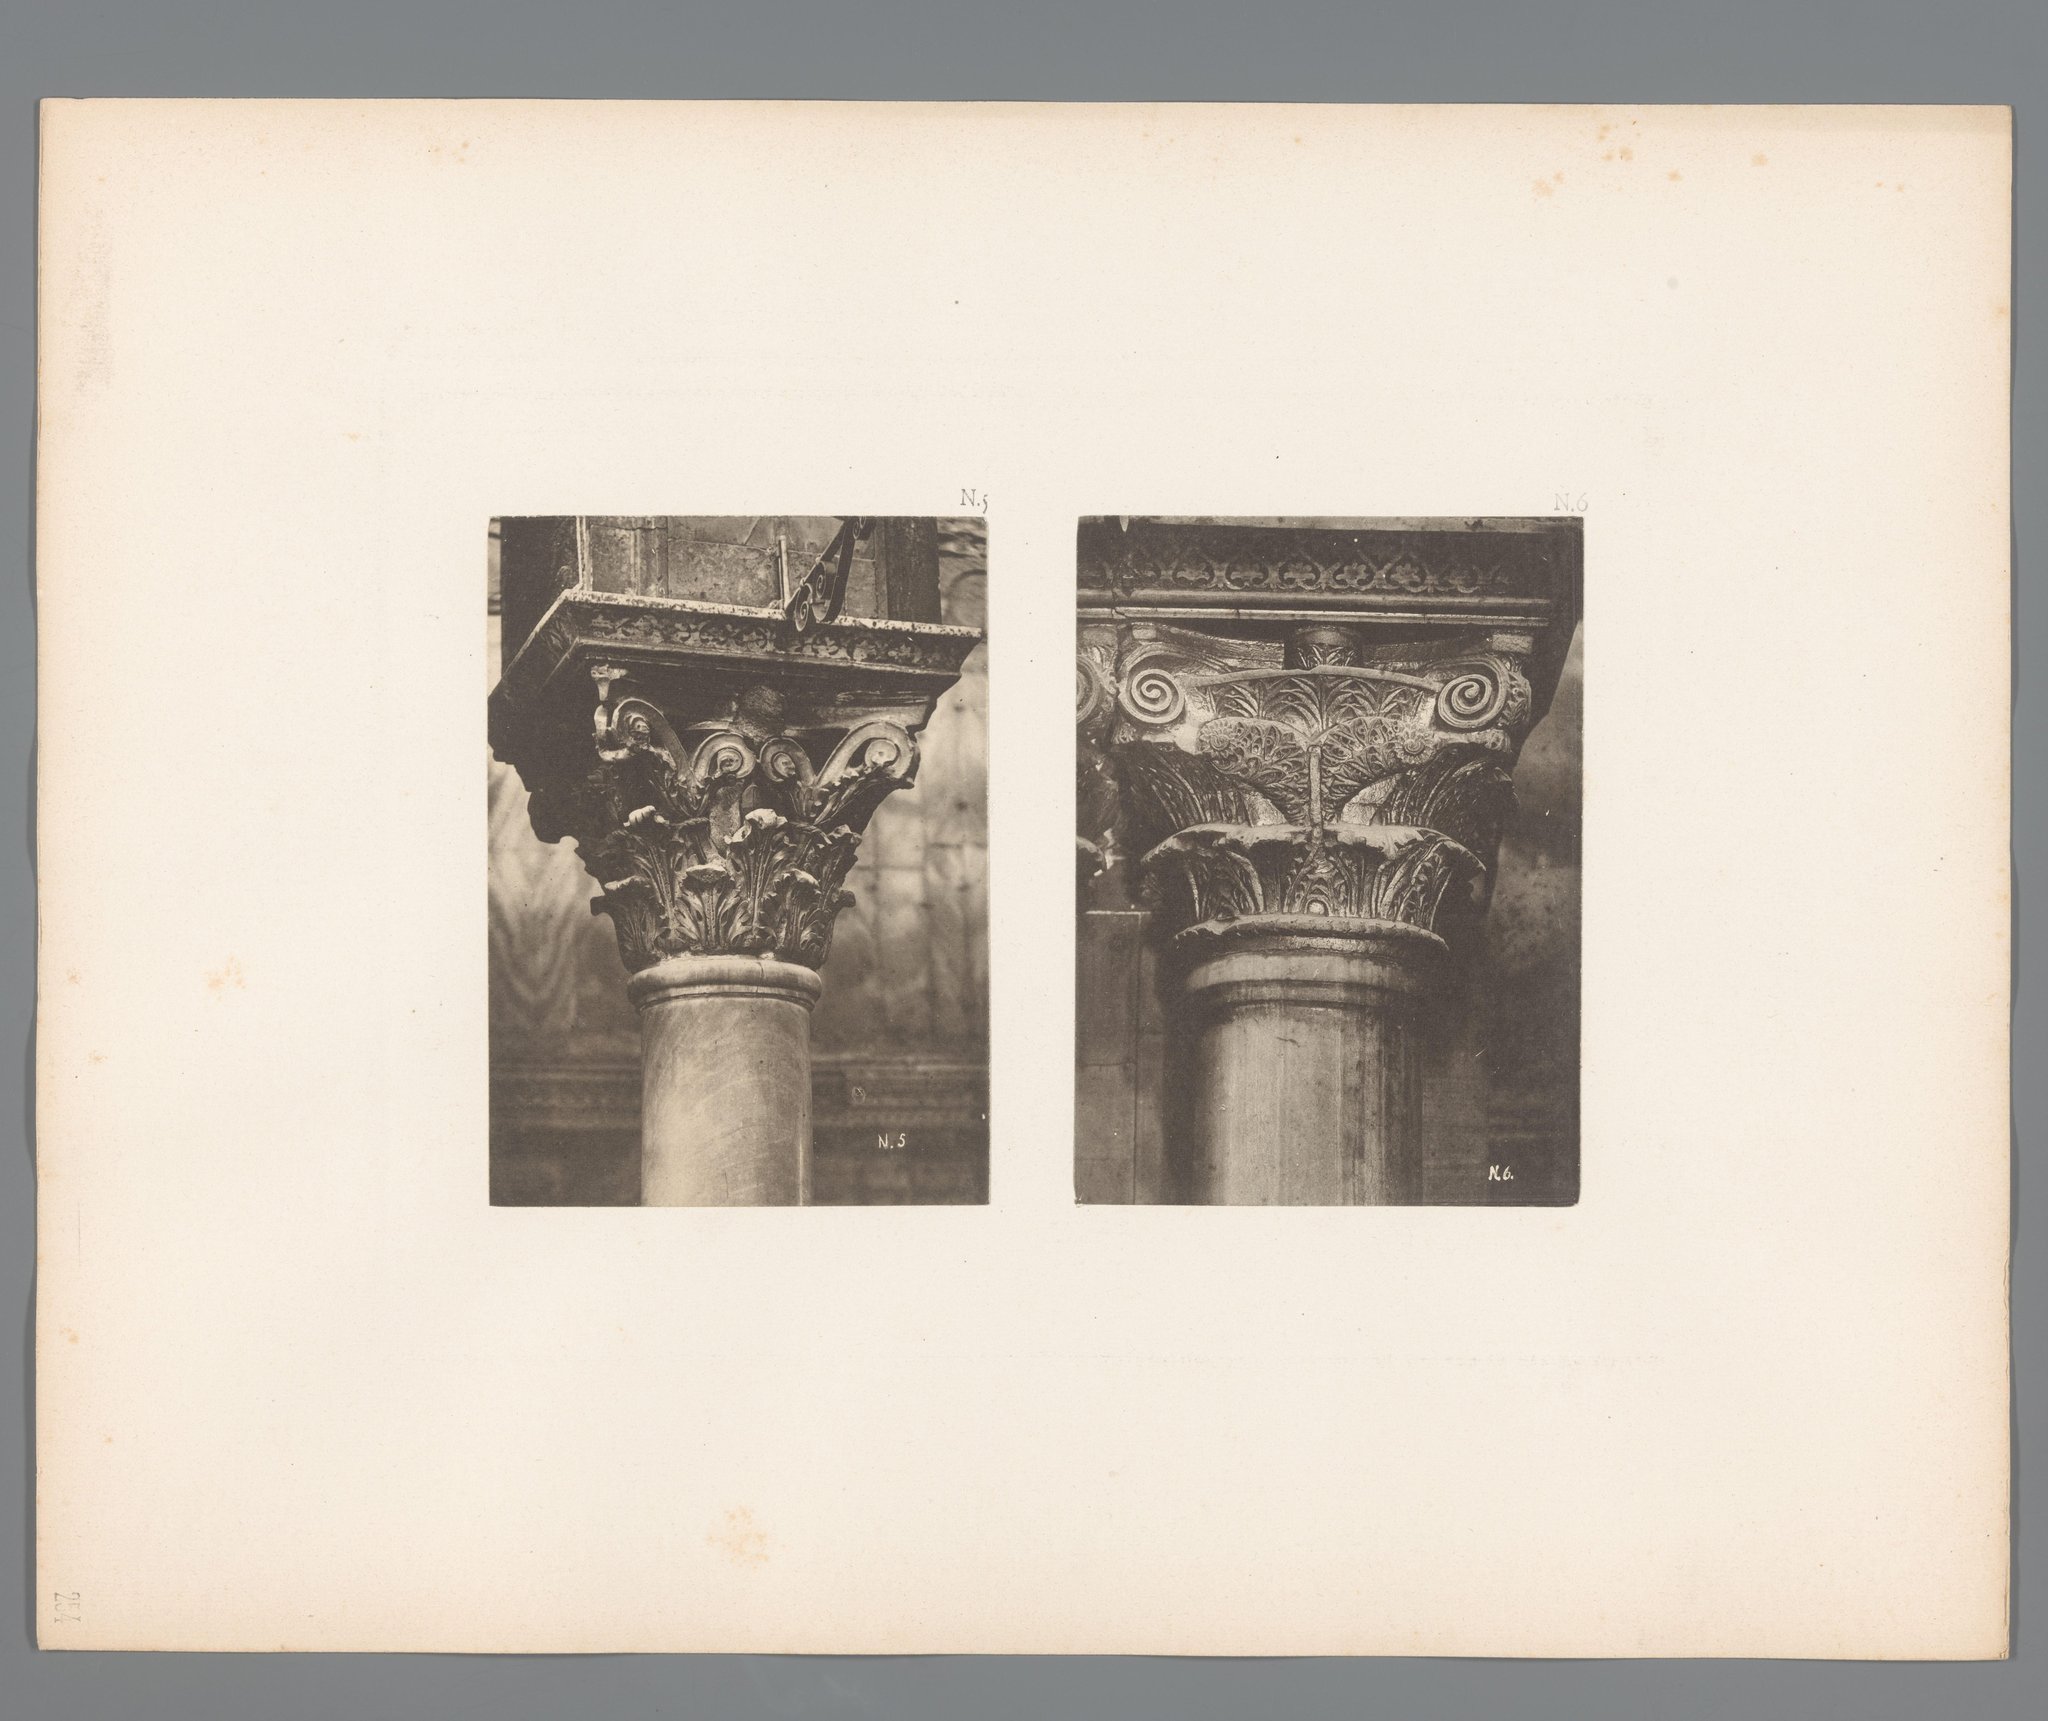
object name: photomechanical print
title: Twee afbeeldingen van Korinthische kapitelen van de San Marco in Venetië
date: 1880-1885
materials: paper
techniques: photograph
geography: venice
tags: capital (~ column, pillar) (+ classical art), church (exterior), corinthian order ~ architecture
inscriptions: number: ‘254’, number: ‘N.6’, number: ‘N.6.’, number: ‘N.5’, number: ‘N.5’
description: Deze prenten maken deel uit van een omslag met 58 prenten op 50 bladen.